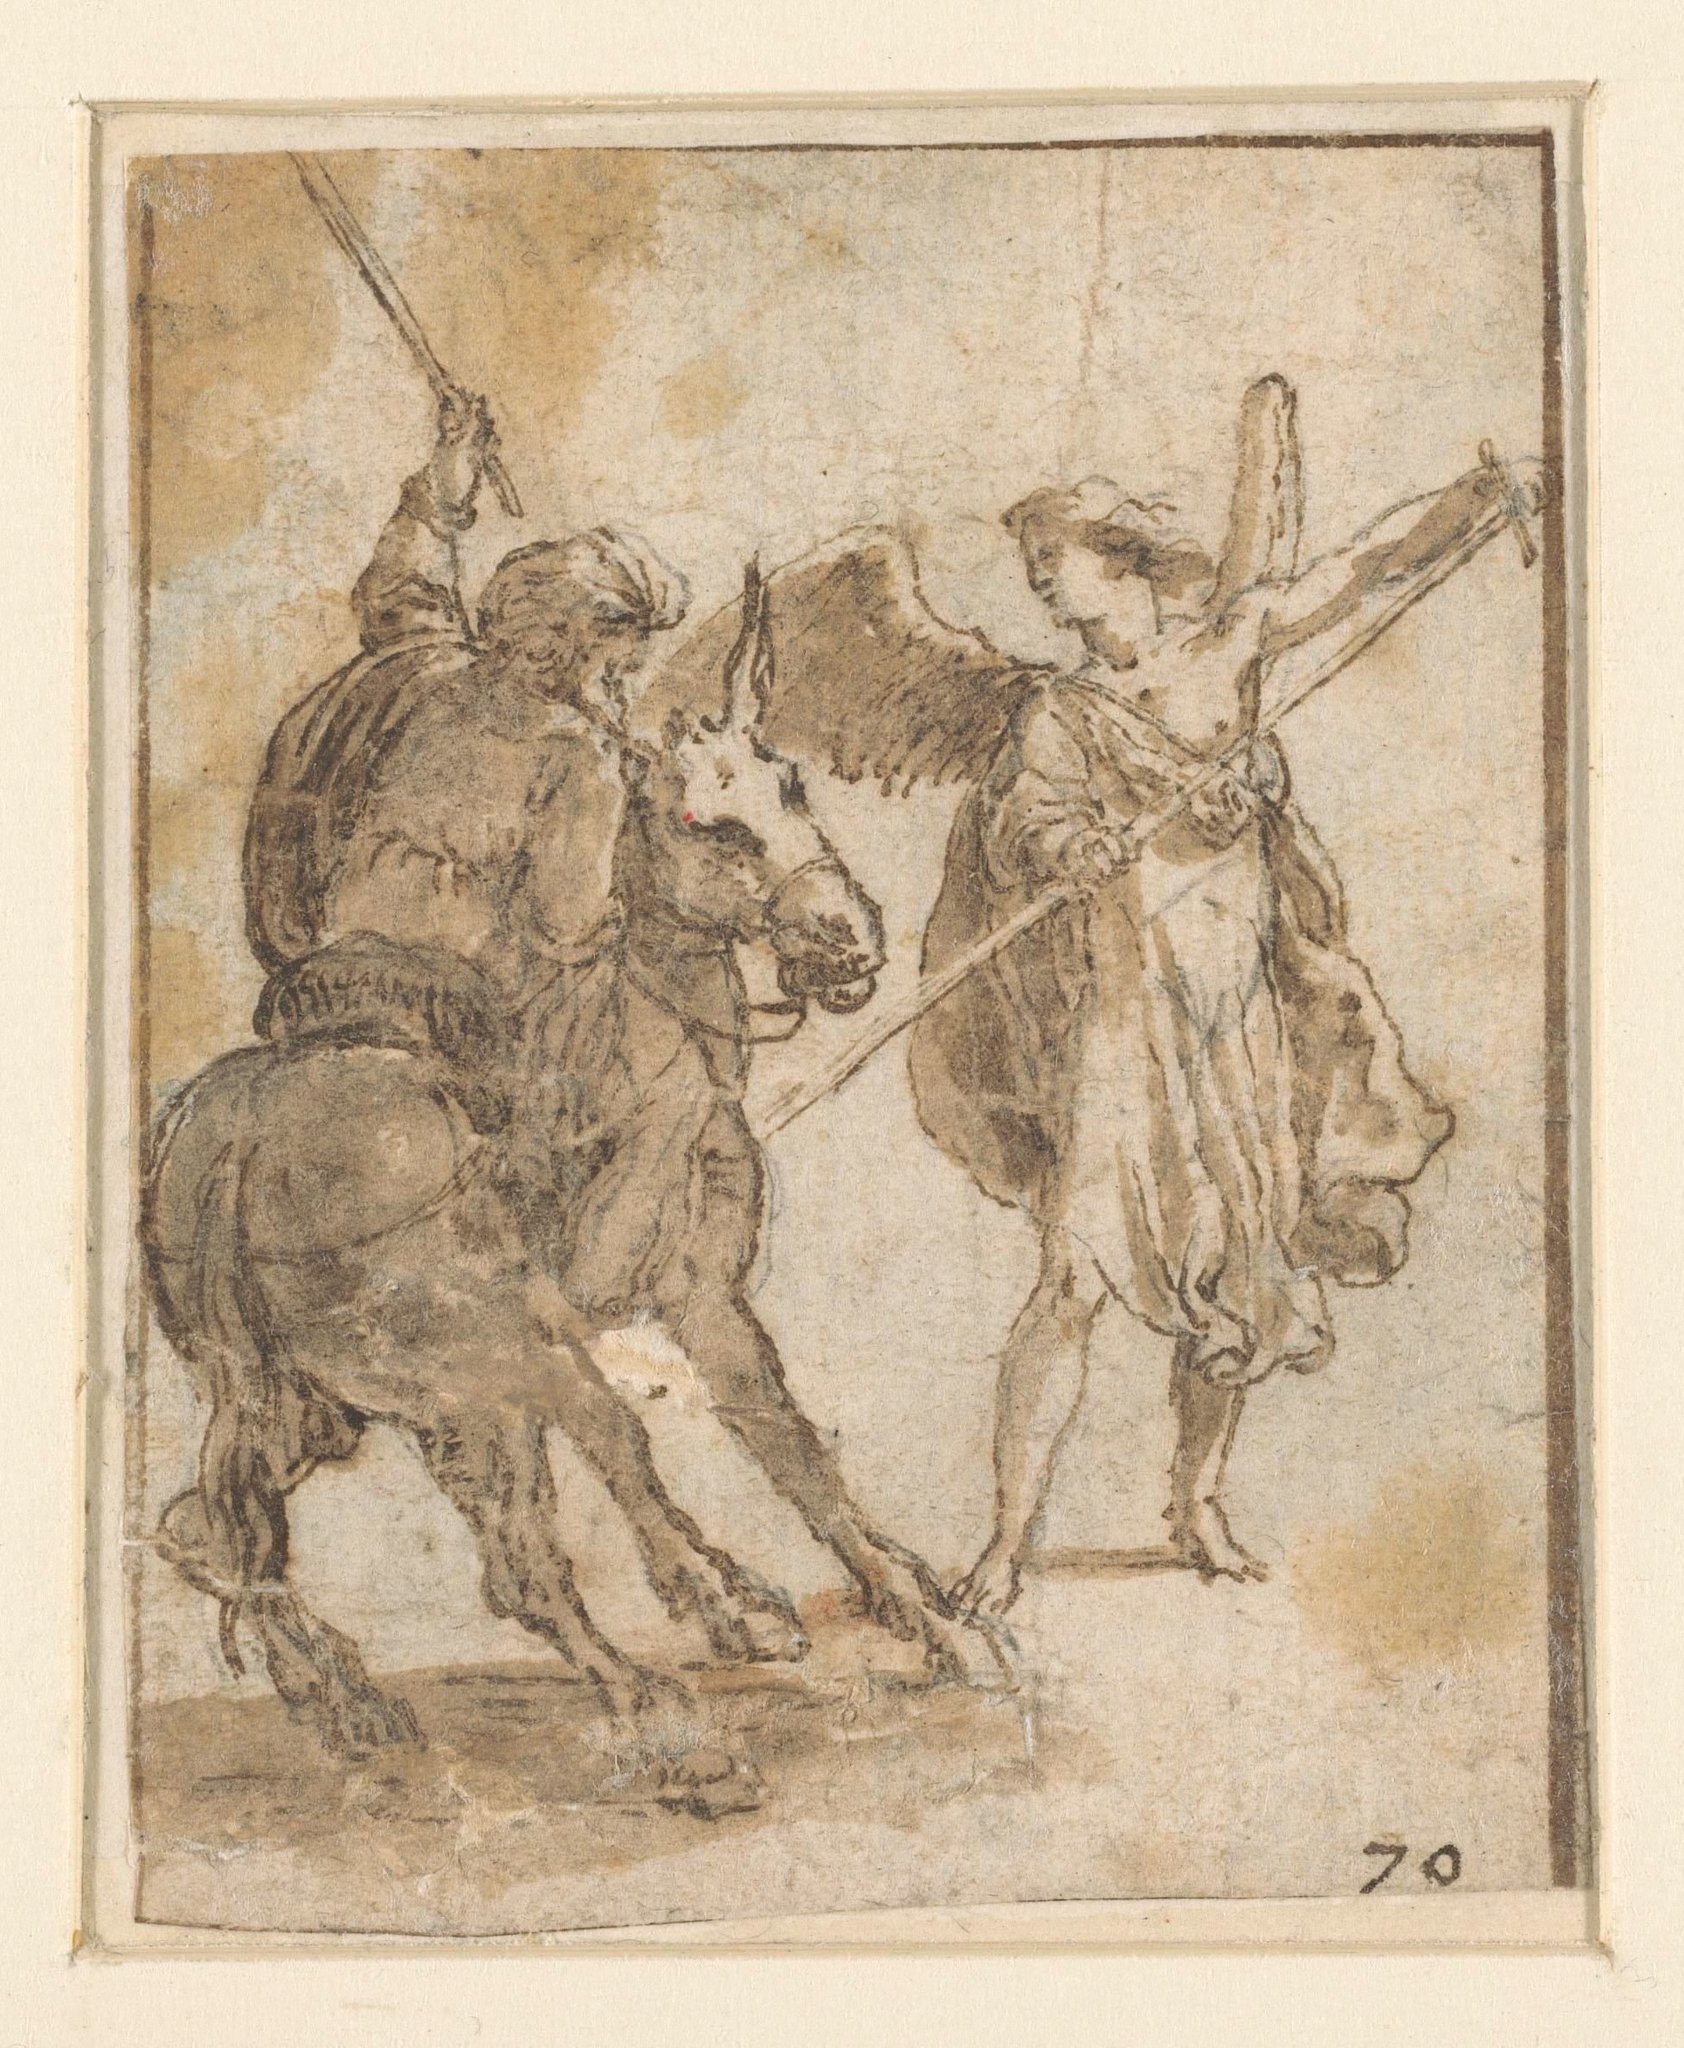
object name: drawing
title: Bileam op zijn ezel ontmoet de engel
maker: adam elsheimer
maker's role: draughtsman, print maker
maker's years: 1578-1610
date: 1588-1610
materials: ink, paper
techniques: brush, pen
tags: balaam saddles his donkey and departs with the moabite messengers, ass, donkey